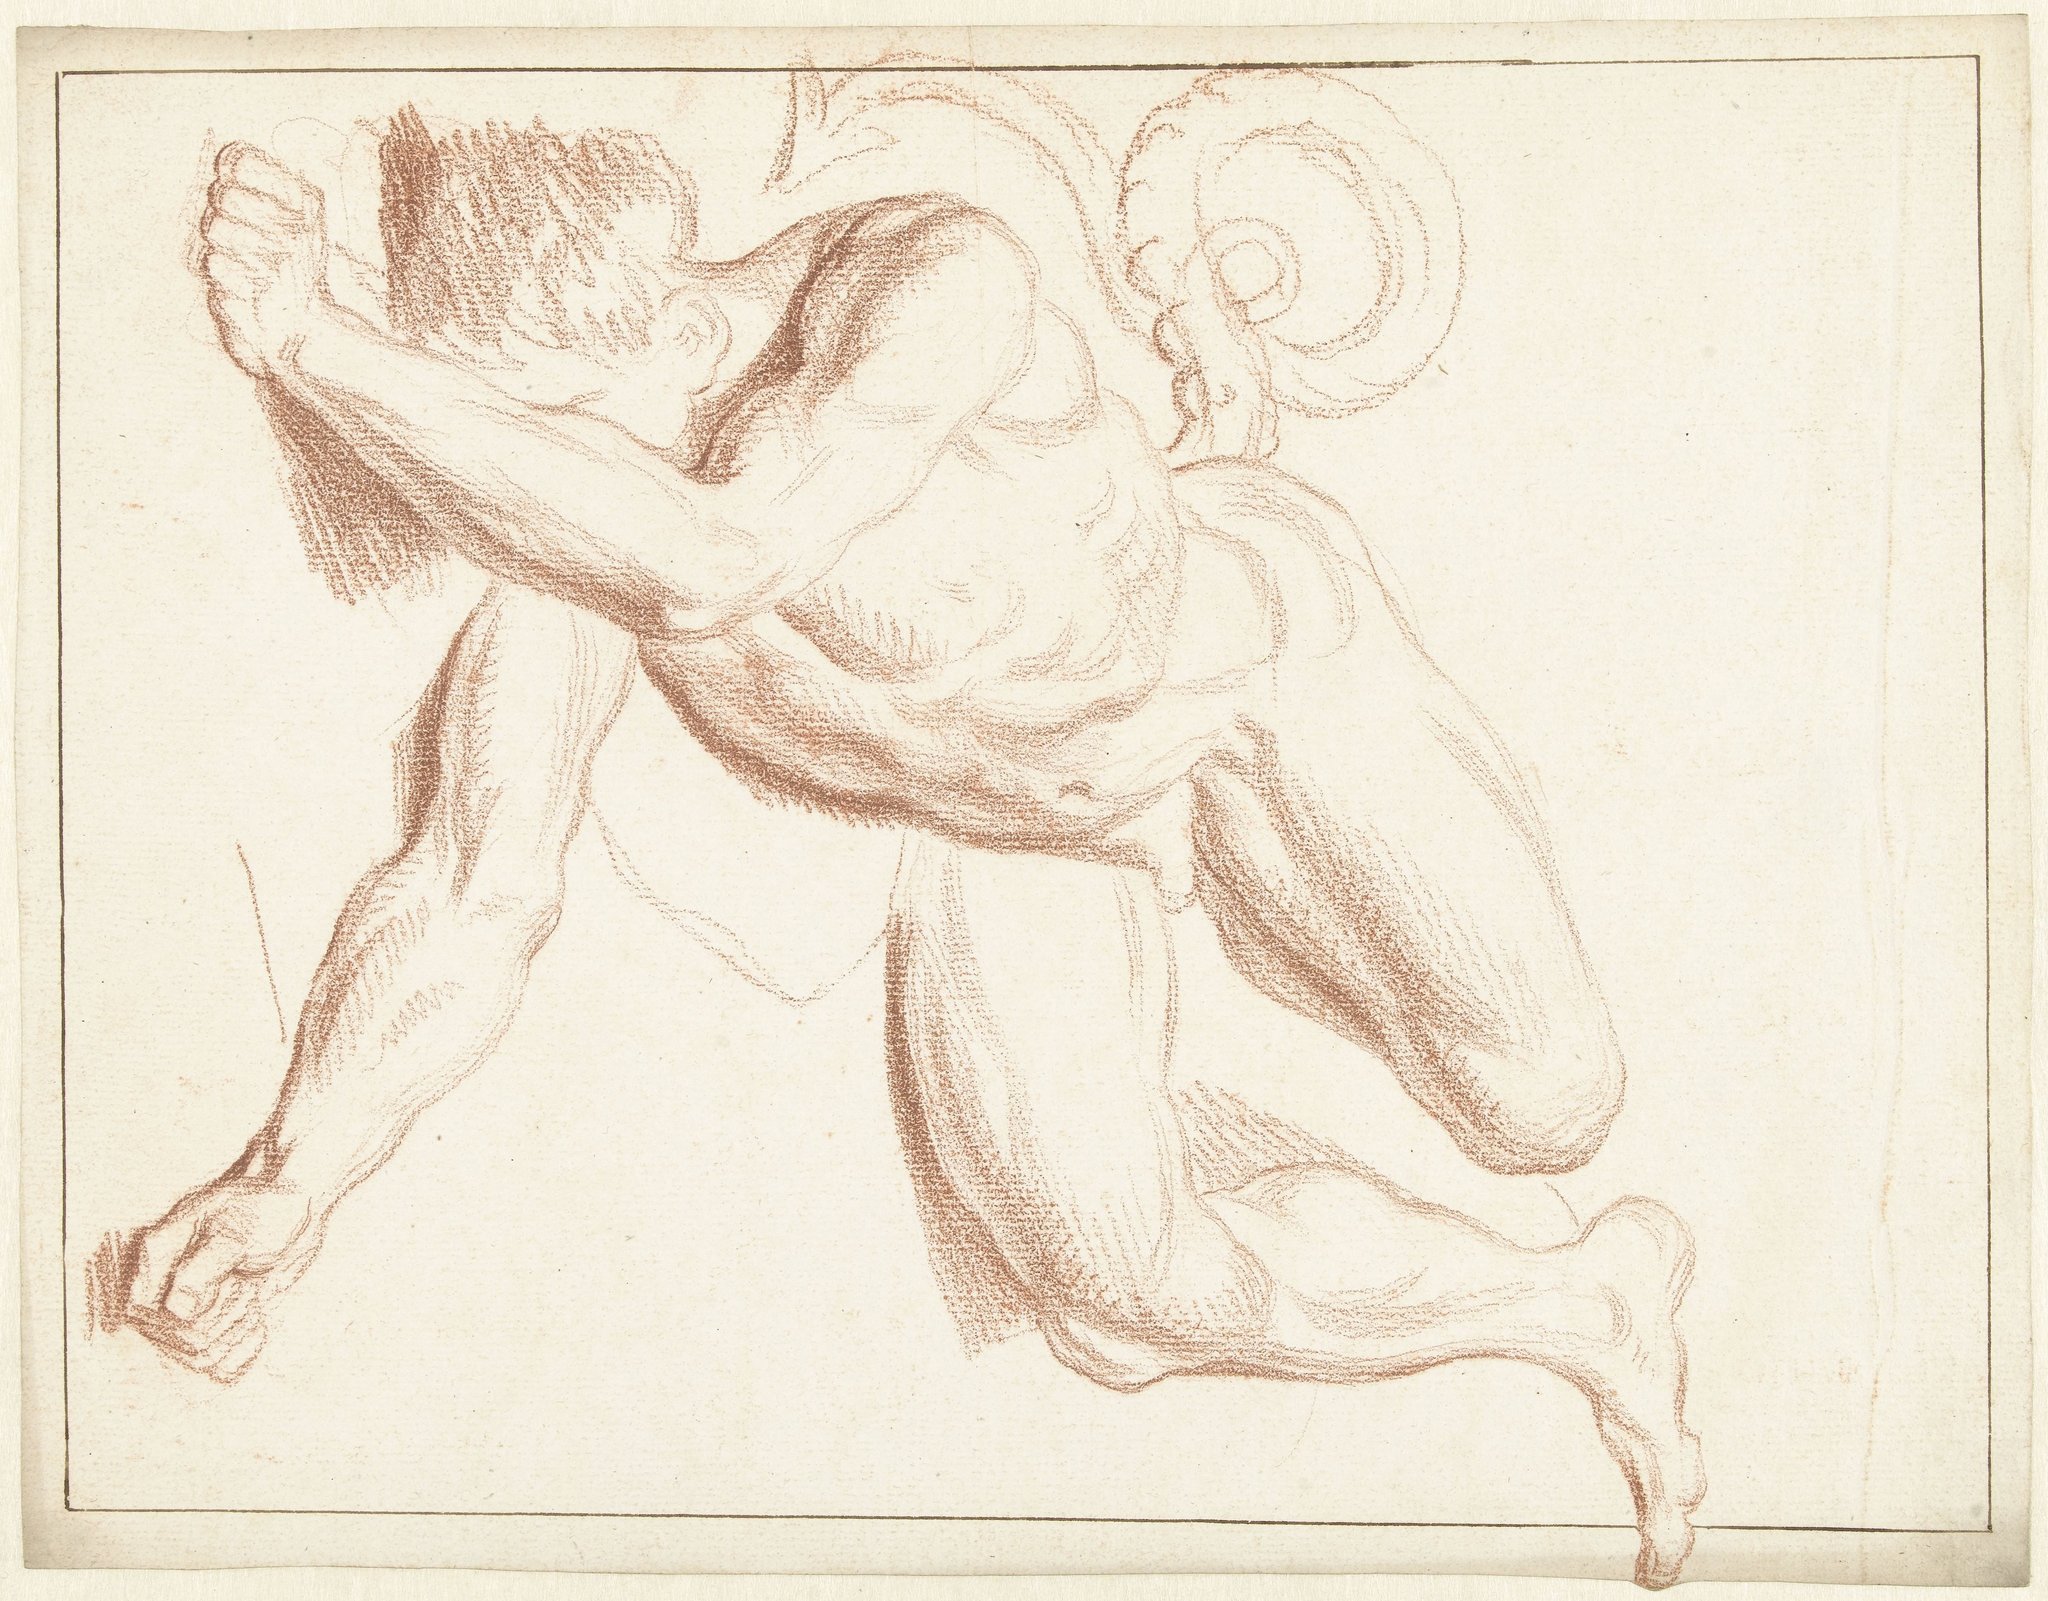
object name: drawing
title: Studie van een mannelijk naakt, liggend op zijn zij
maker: louis fabritius dubourg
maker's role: draughtsman, print maker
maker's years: 1693-1775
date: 1703-1775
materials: chalk, paper